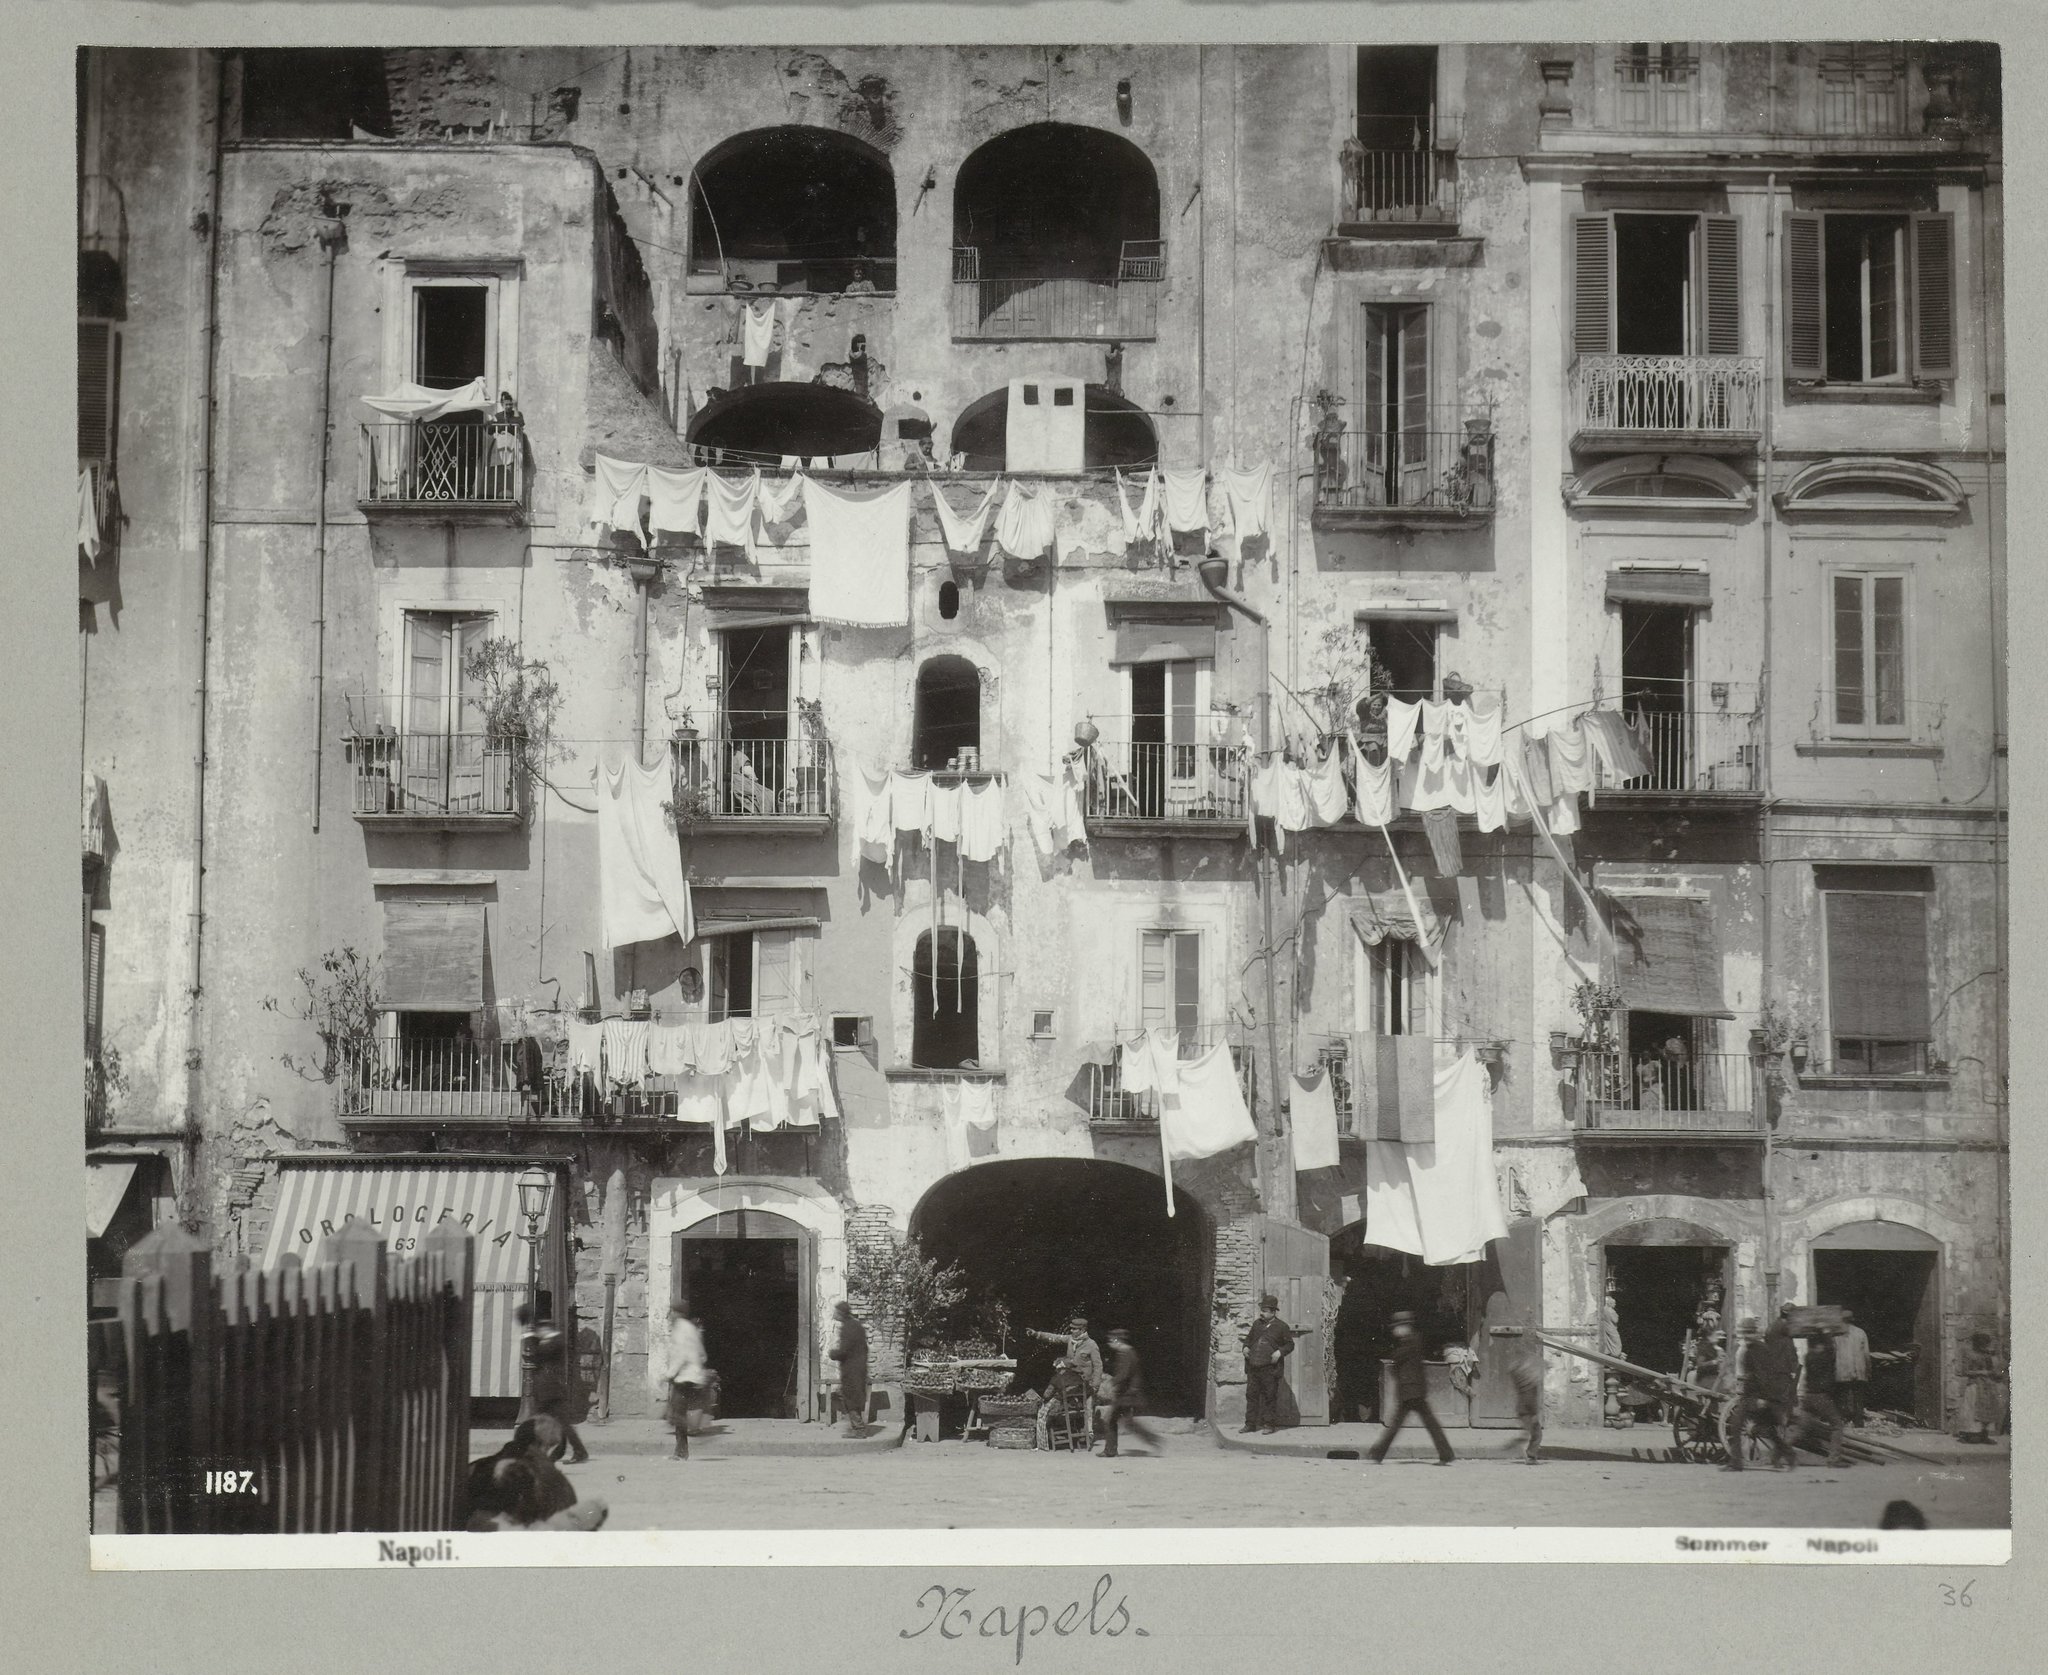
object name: photograph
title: Napels.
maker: giorgio sommer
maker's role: fotograaf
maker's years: 1834-1914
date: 1893-1903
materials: cardboard, photographic support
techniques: albumen print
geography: netherlands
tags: naples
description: Woningen in Napels met buiten hangende was.